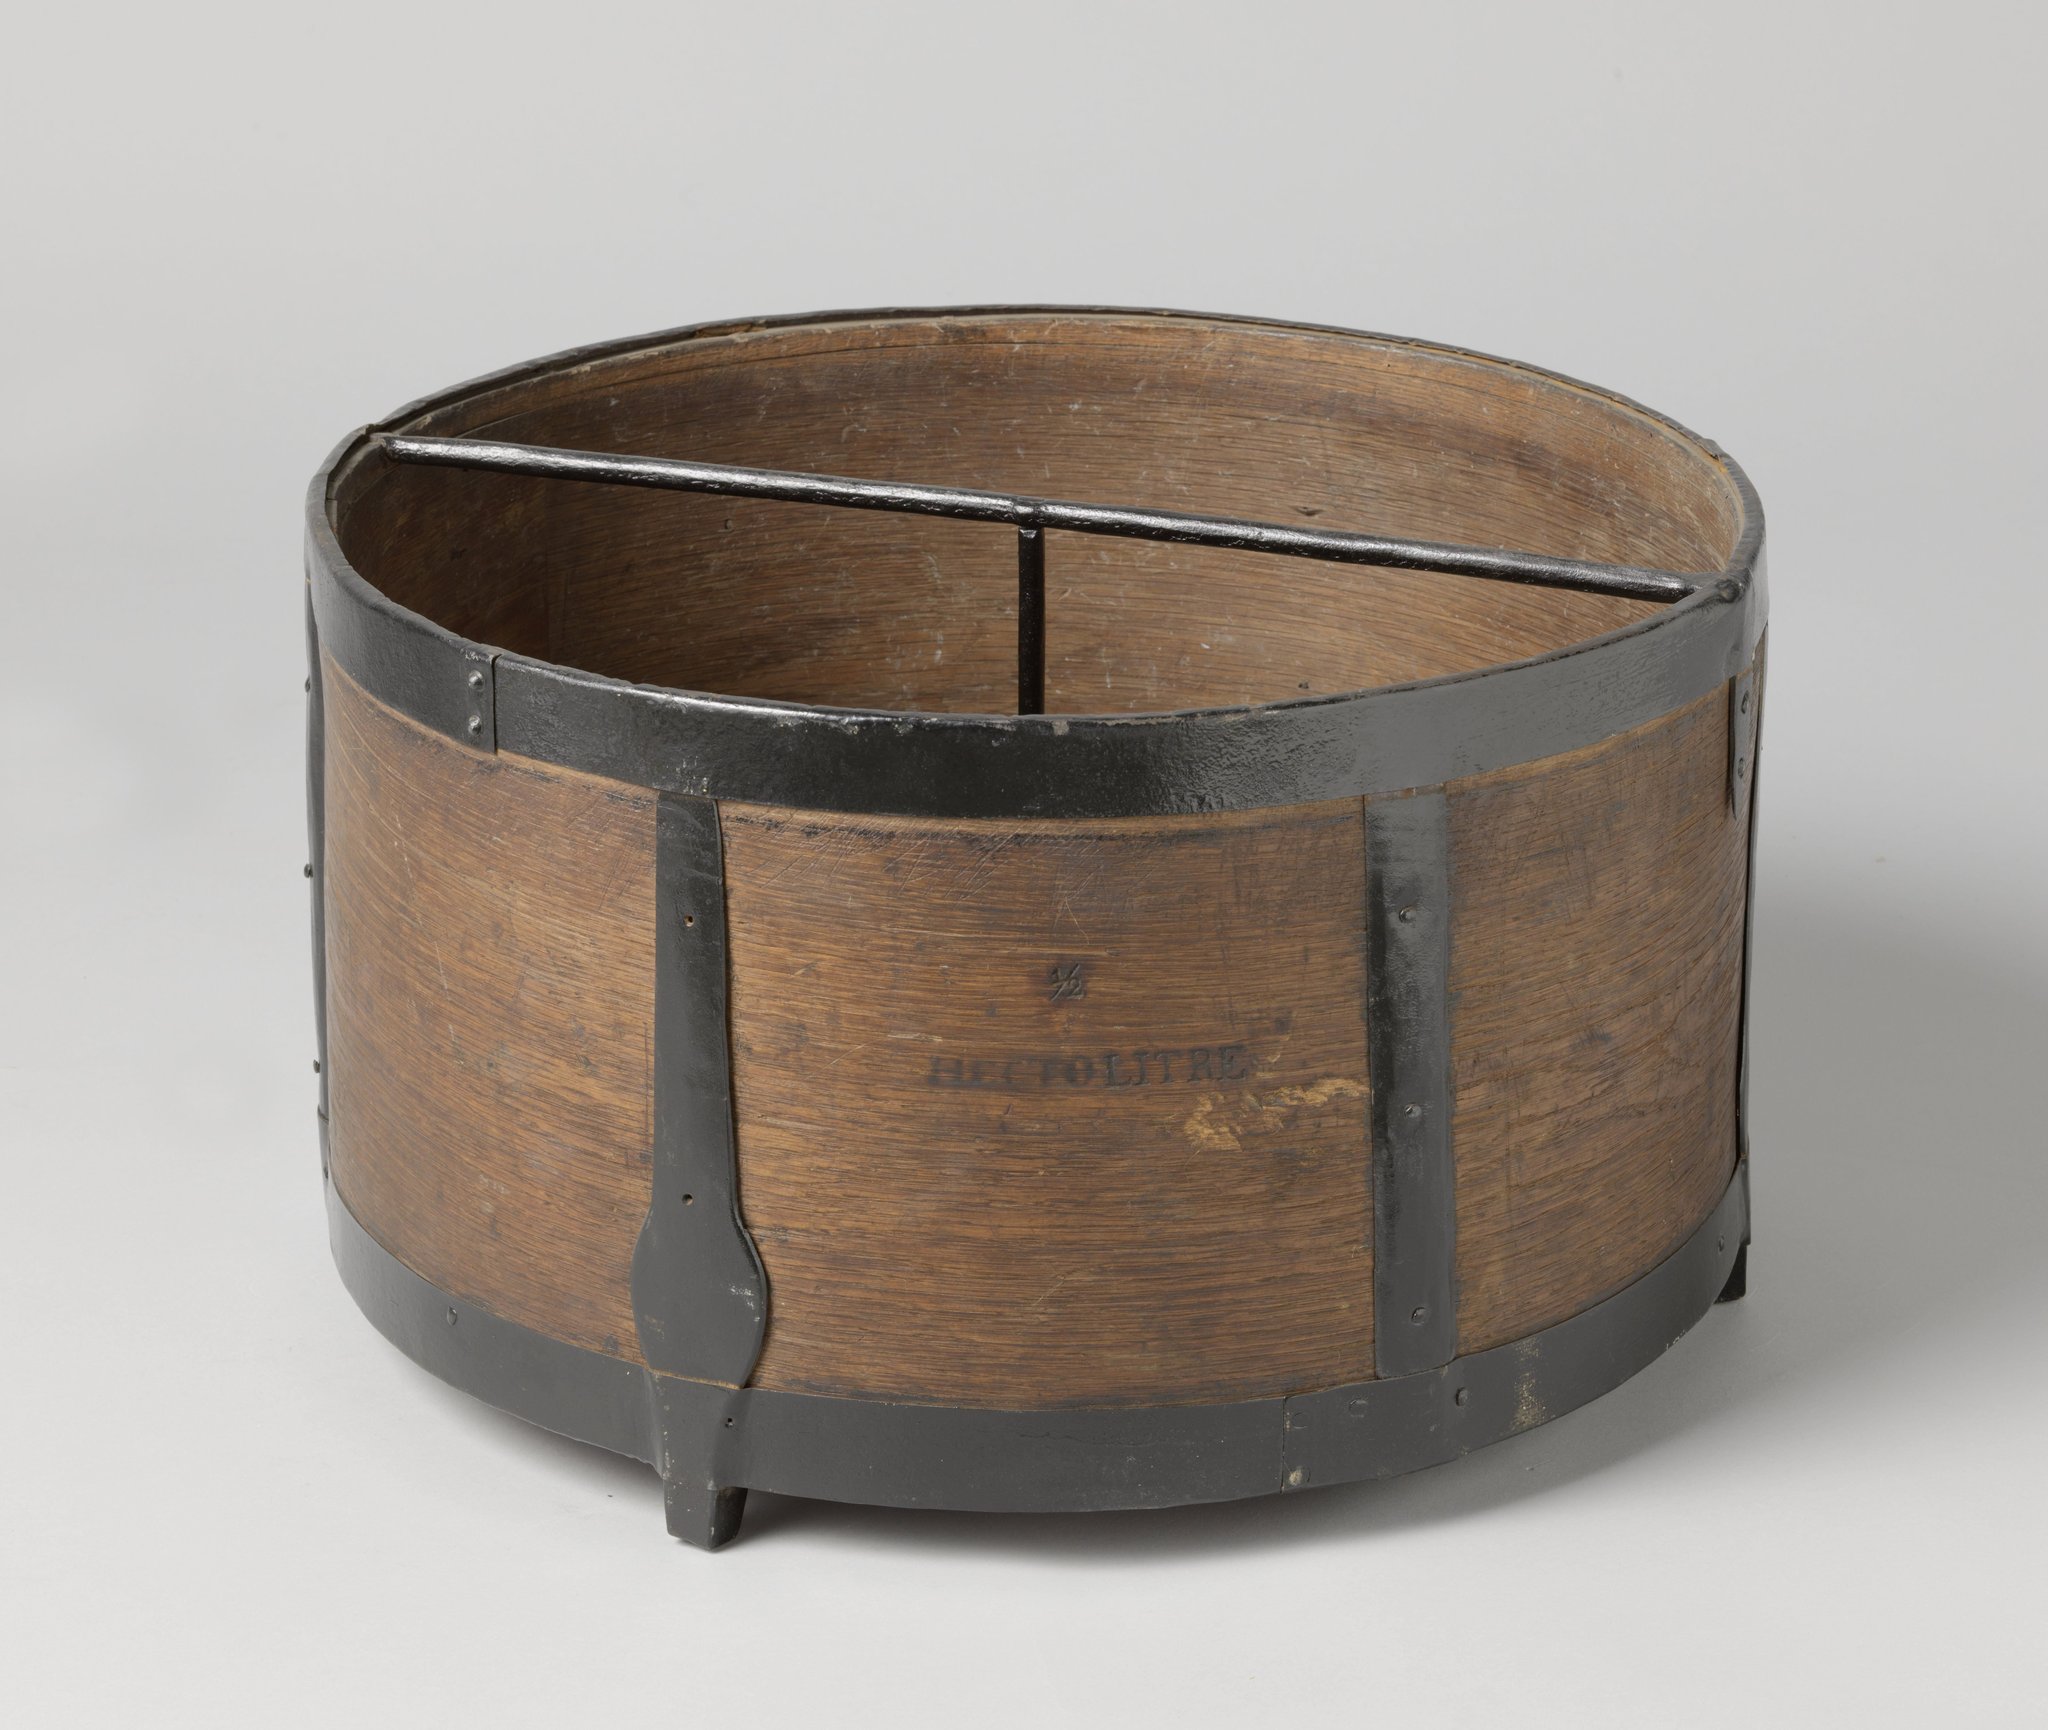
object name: inhoudsmaat droge waren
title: Inhoudsmaat van 1 hectoliter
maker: Anonymous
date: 1815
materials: iron, wood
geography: netherlands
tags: netherlands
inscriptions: title: ‘1/2 HECTOLITRE’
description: Spanen en ijzeren inhoudsmaat voor droge waren met brug en stijl van 1 hectoliter, v.z.v. opschrift.